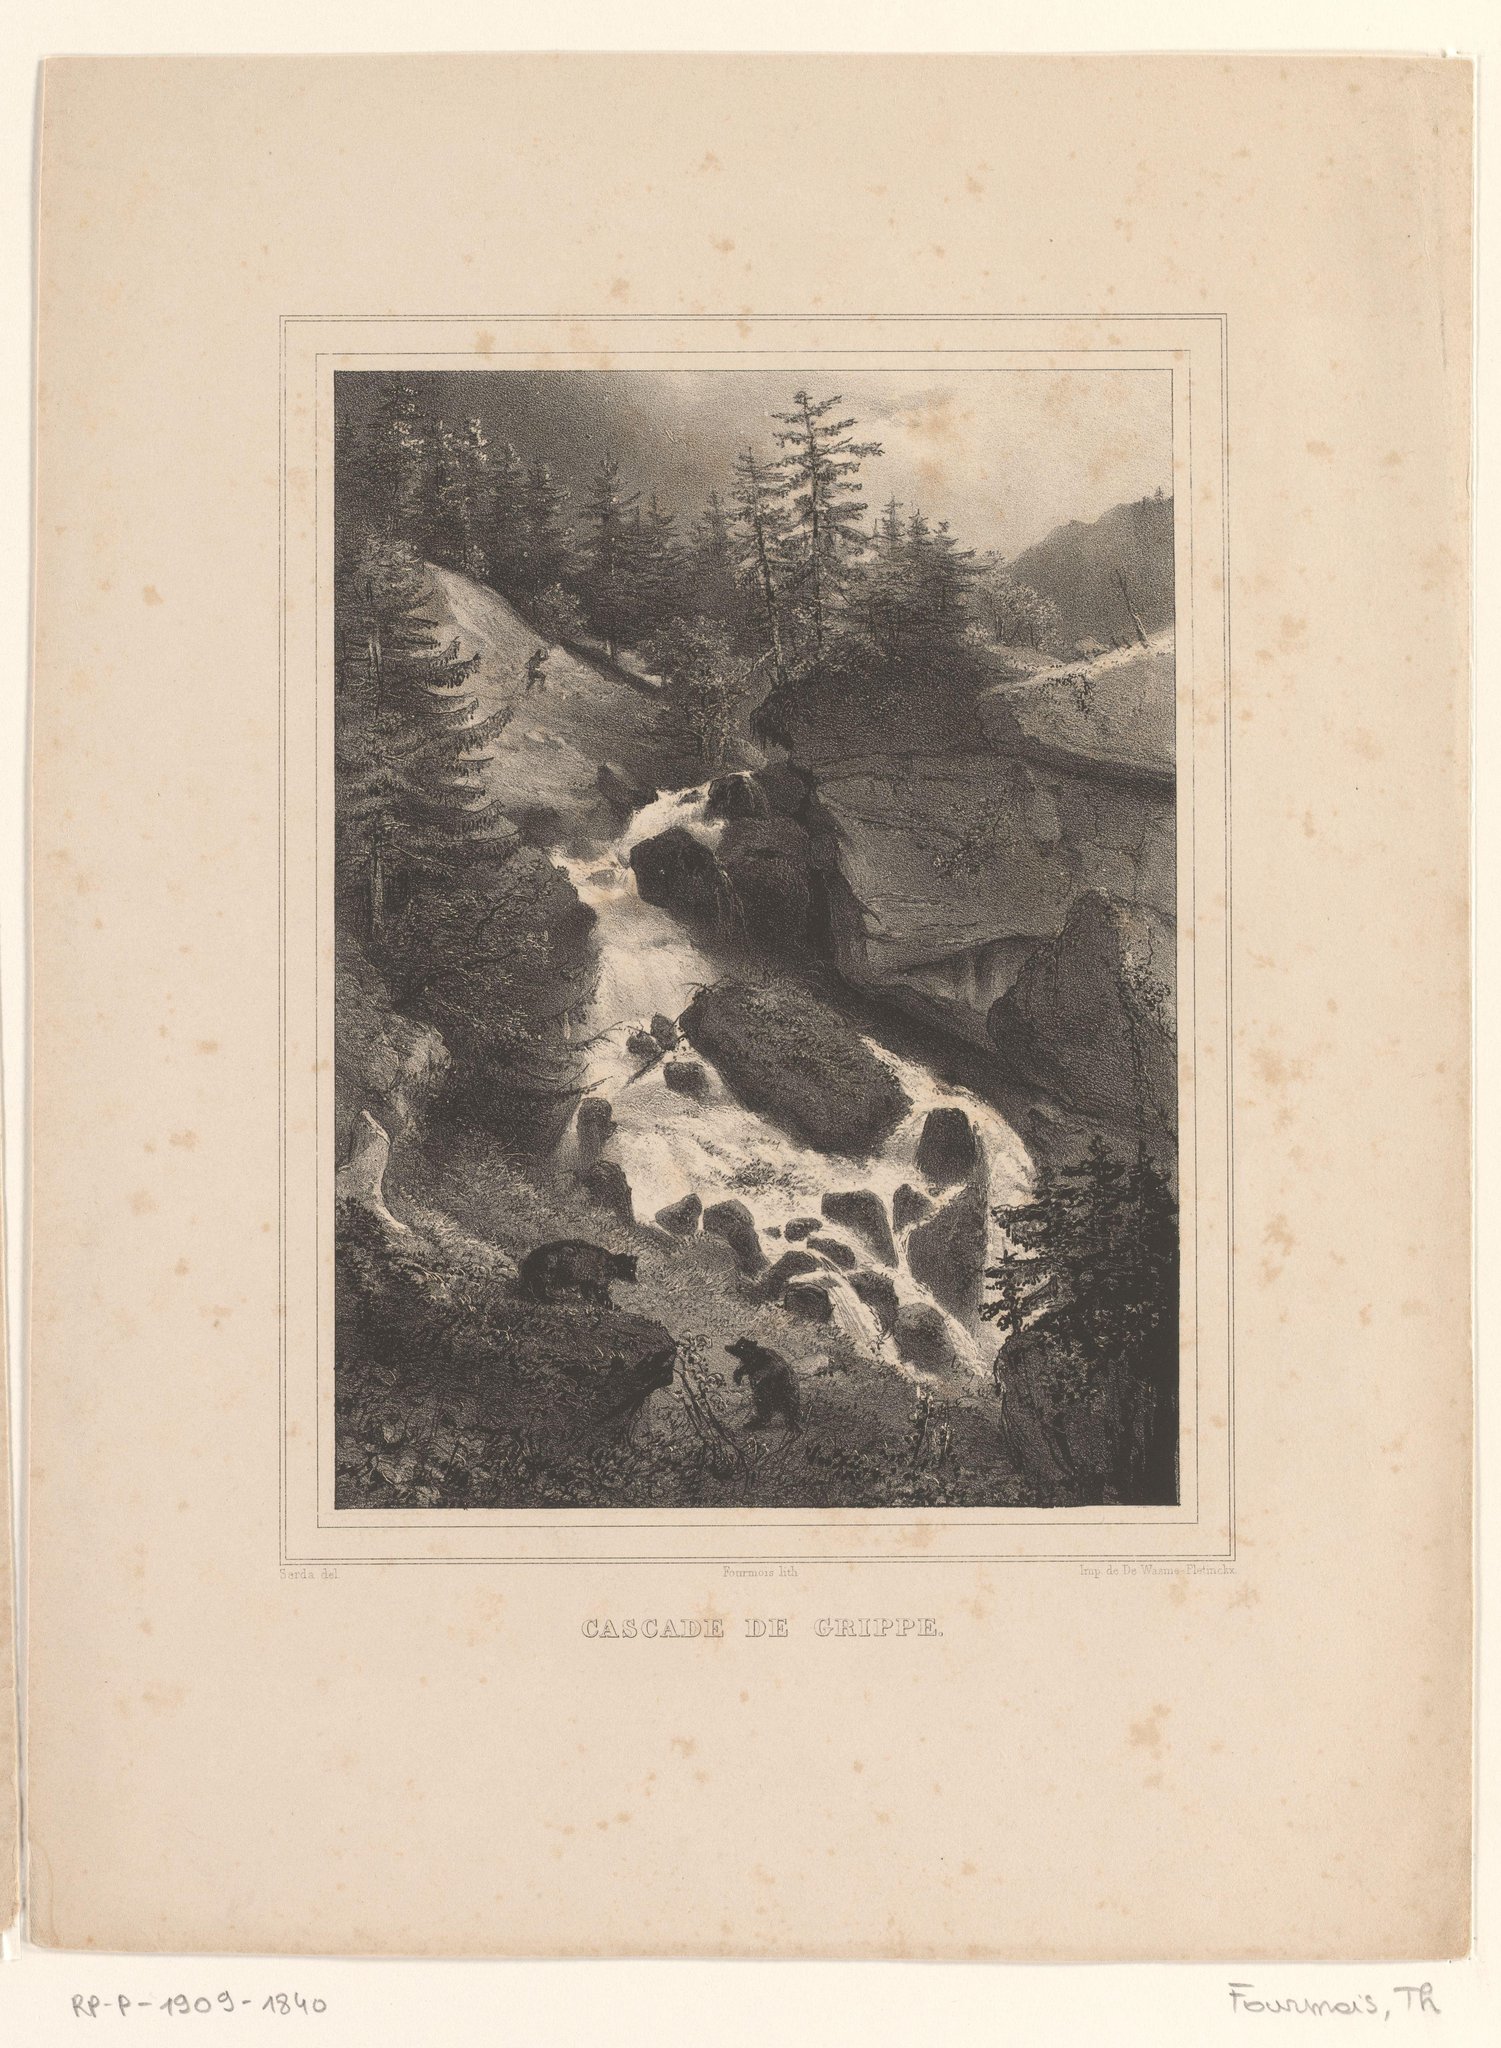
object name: print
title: Cascade de Grippe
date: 1835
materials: paper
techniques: lithograph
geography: brussels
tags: waterfall, mountains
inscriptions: collector's mark: Lugt 2228